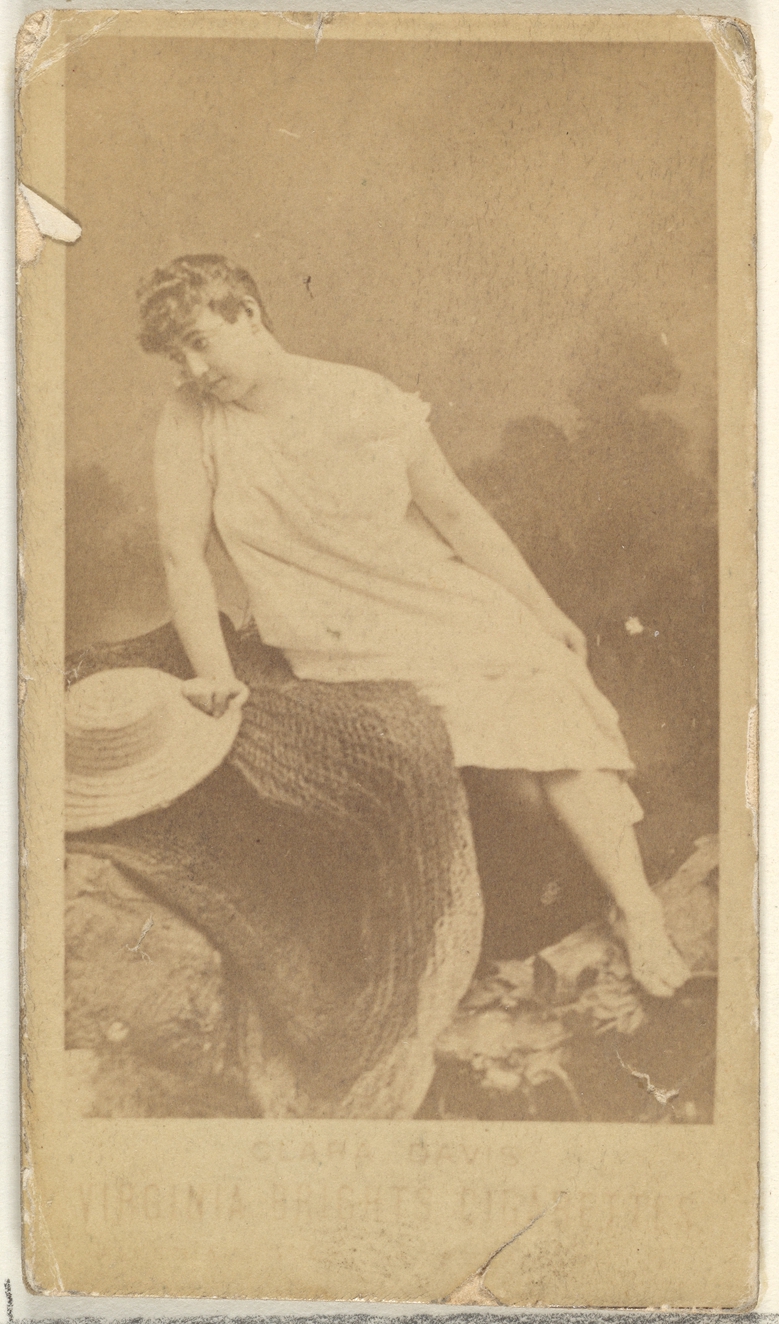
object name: photograph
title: Clara Davis, from the Actors and Actresses series (N45, Type 1) for Virginia Brights Cigarettes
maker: allen & ginter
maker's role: publisher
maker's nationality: american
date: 1888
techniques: albumen silver print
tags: portraits,women,actresses